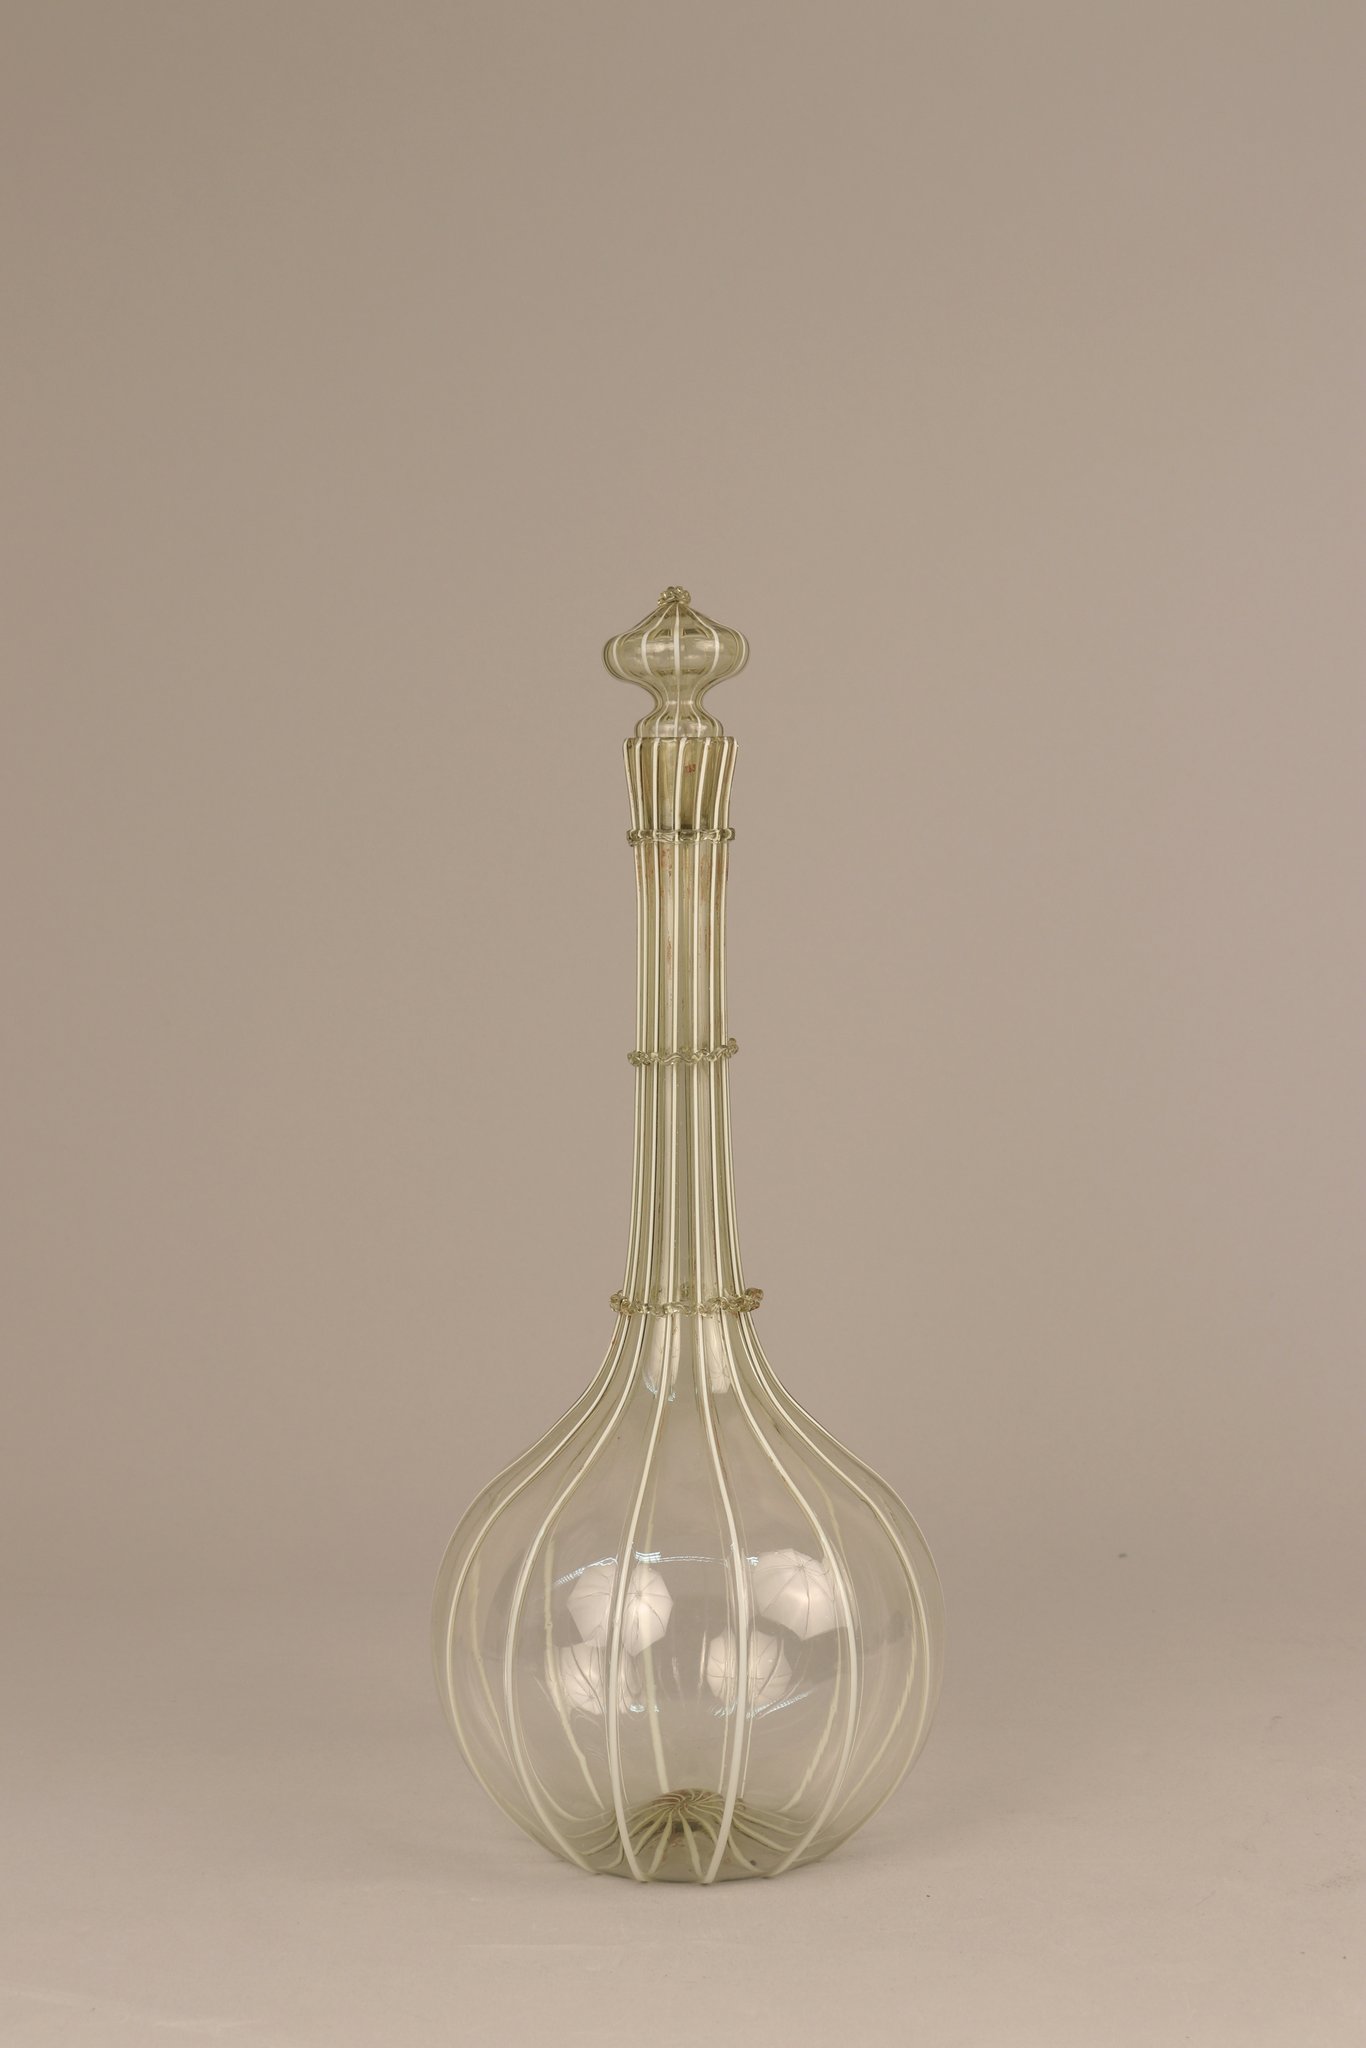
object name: bottle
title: Bottle with stopper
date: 1860-1880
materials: glass